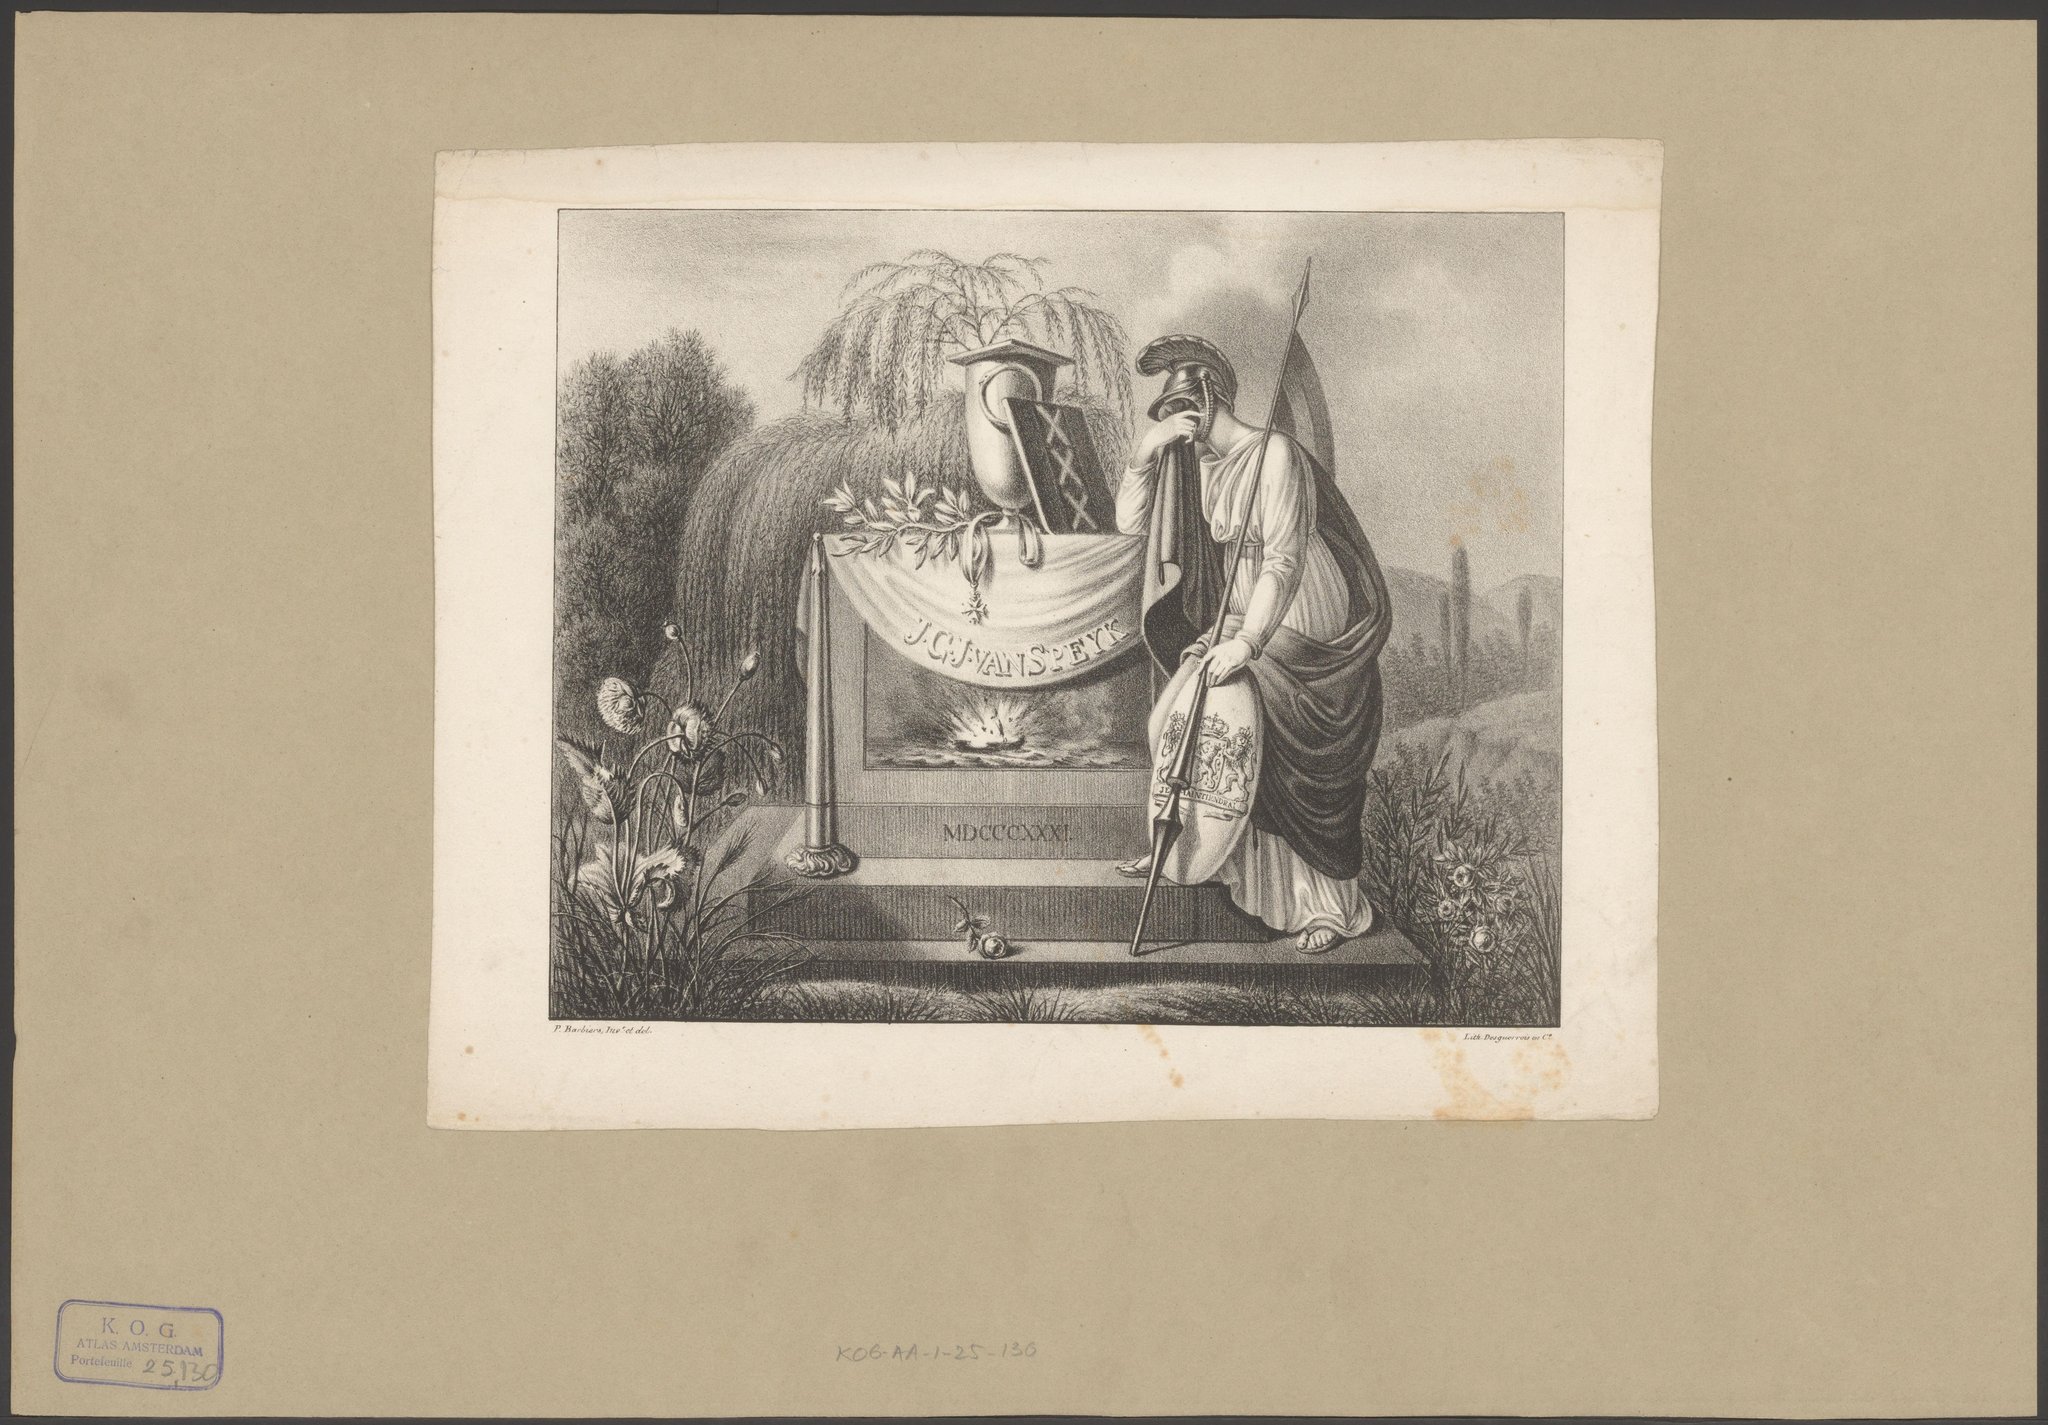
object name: print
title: Grafmonument voor Jan van Speyk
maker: pieter barbiers (iv)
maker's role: painter, print maker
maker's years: 1798-1848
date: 1831-1848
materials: paper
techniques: lithograph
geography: amsterdam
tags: amsterdam, antwerp, jan van speyk, coat of arms (as symbol of the state, etc.), personifications of countries, nations, states, districts, etc., historical persons, grave-building, monumental tomb, commander-in-chief, admiral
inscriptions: collector's mark: ‘25.130’